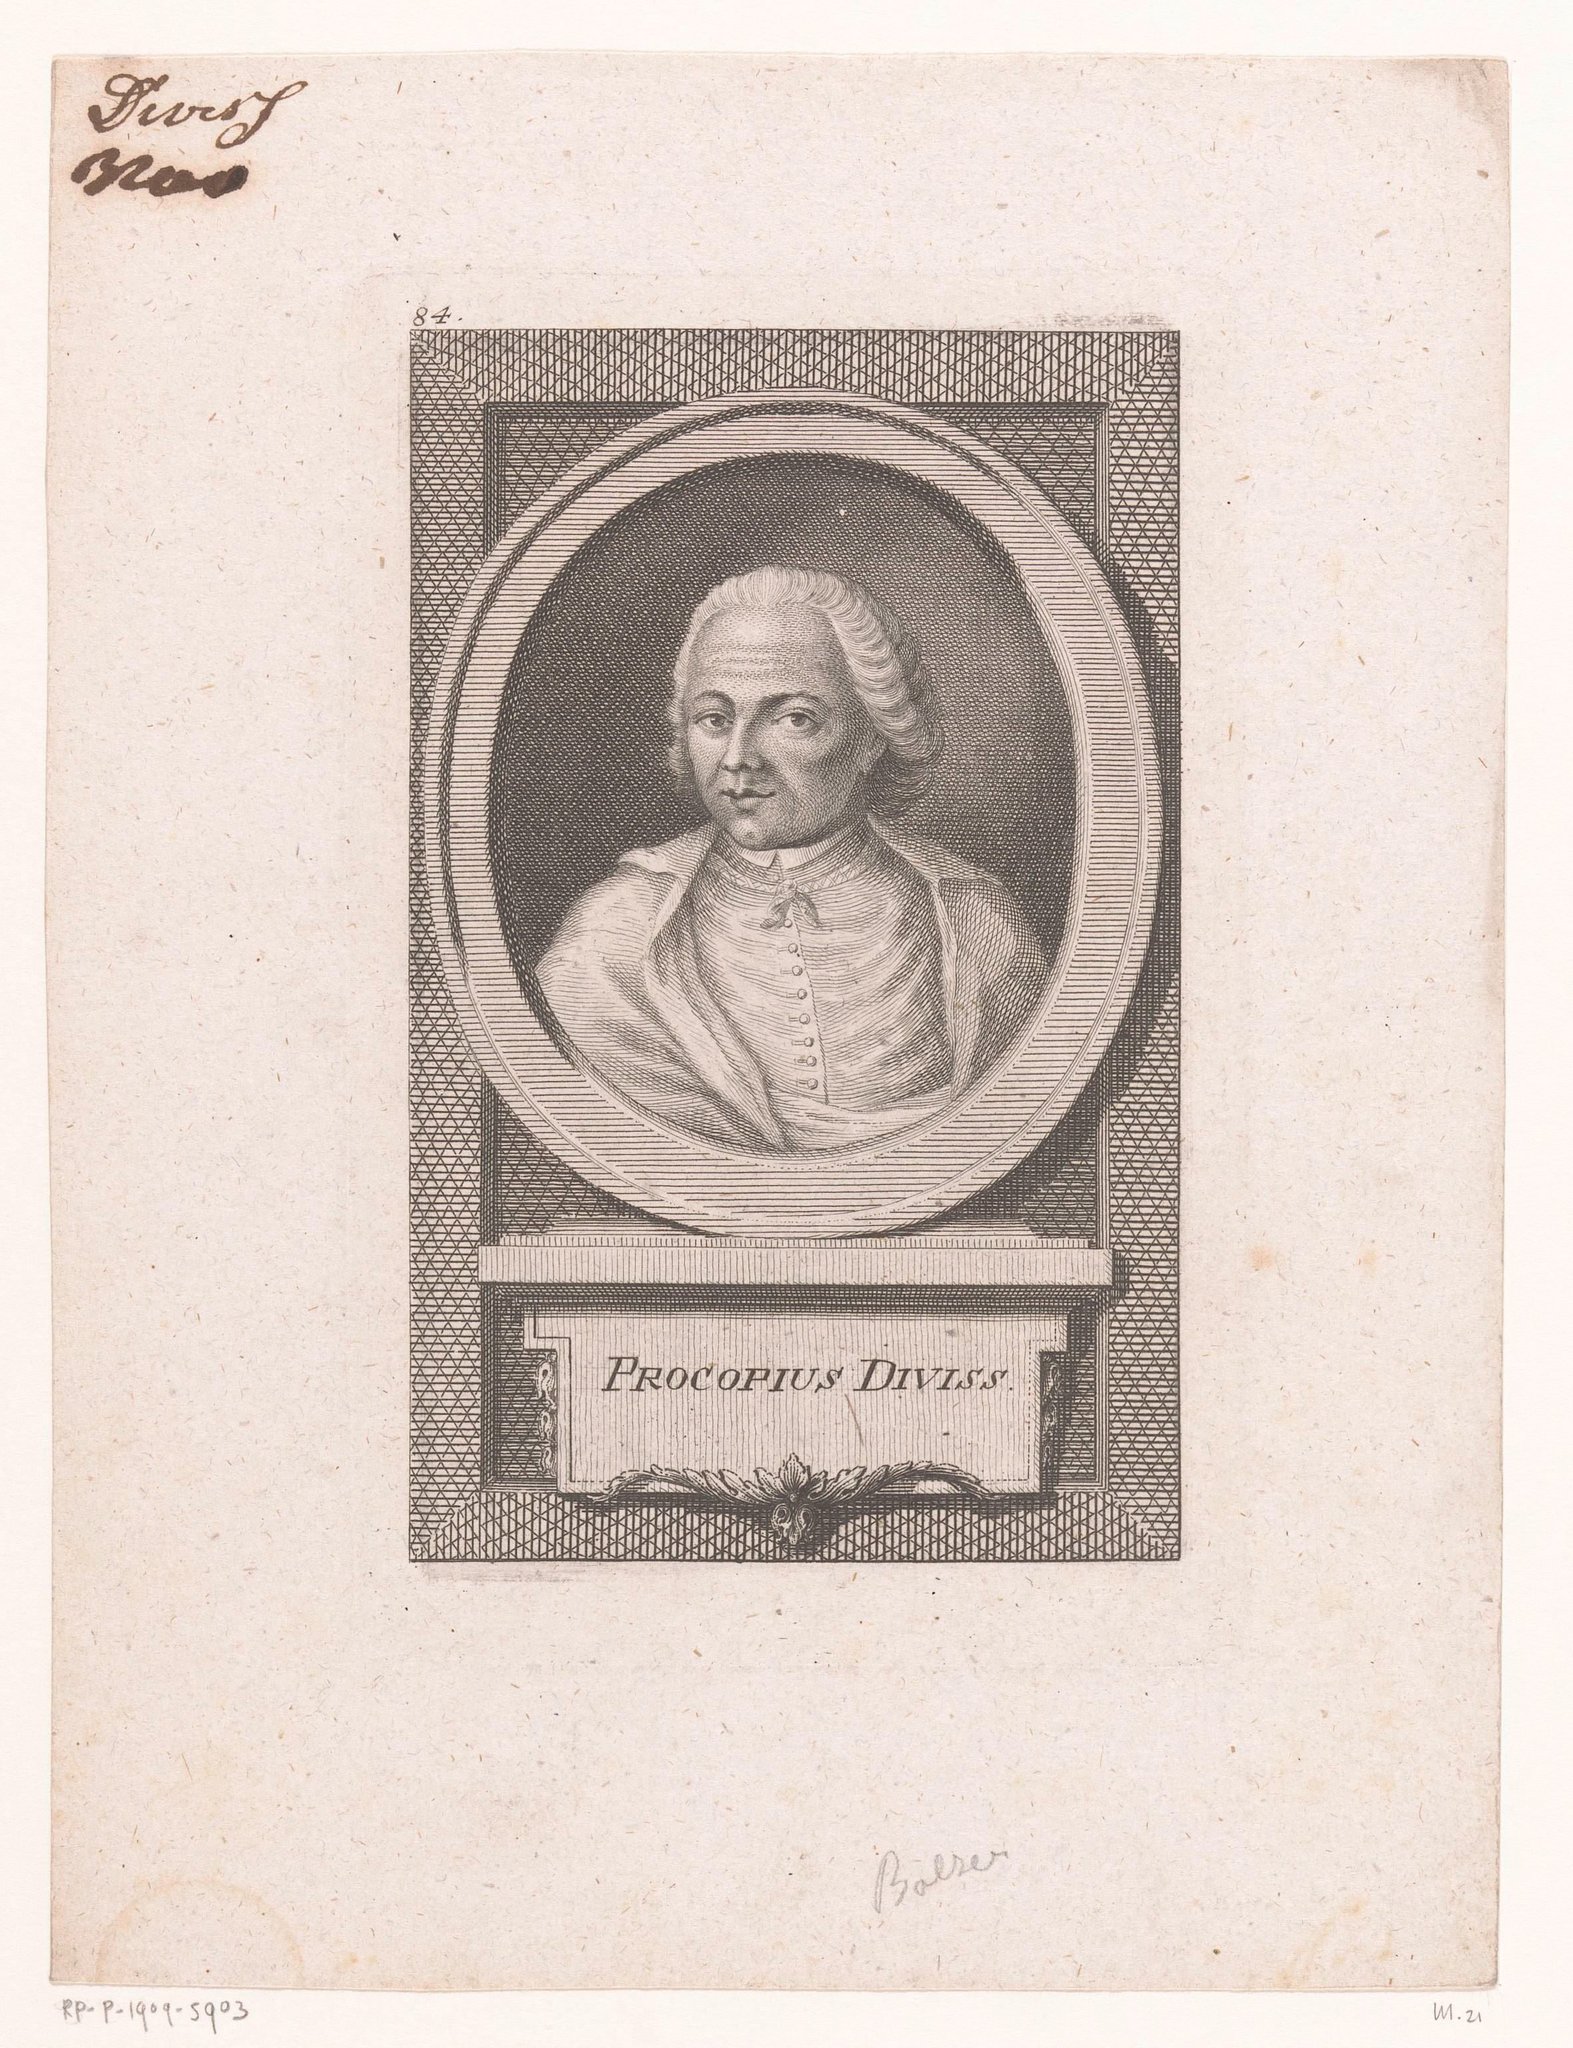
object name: print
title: Procopius Diviss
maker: jan balzer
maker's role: print maker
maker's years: 1736-1799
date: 1746-1799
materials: paper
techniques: engraving, etching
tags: clergyman, historical persons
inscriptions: collector's mark: Lugt 2228